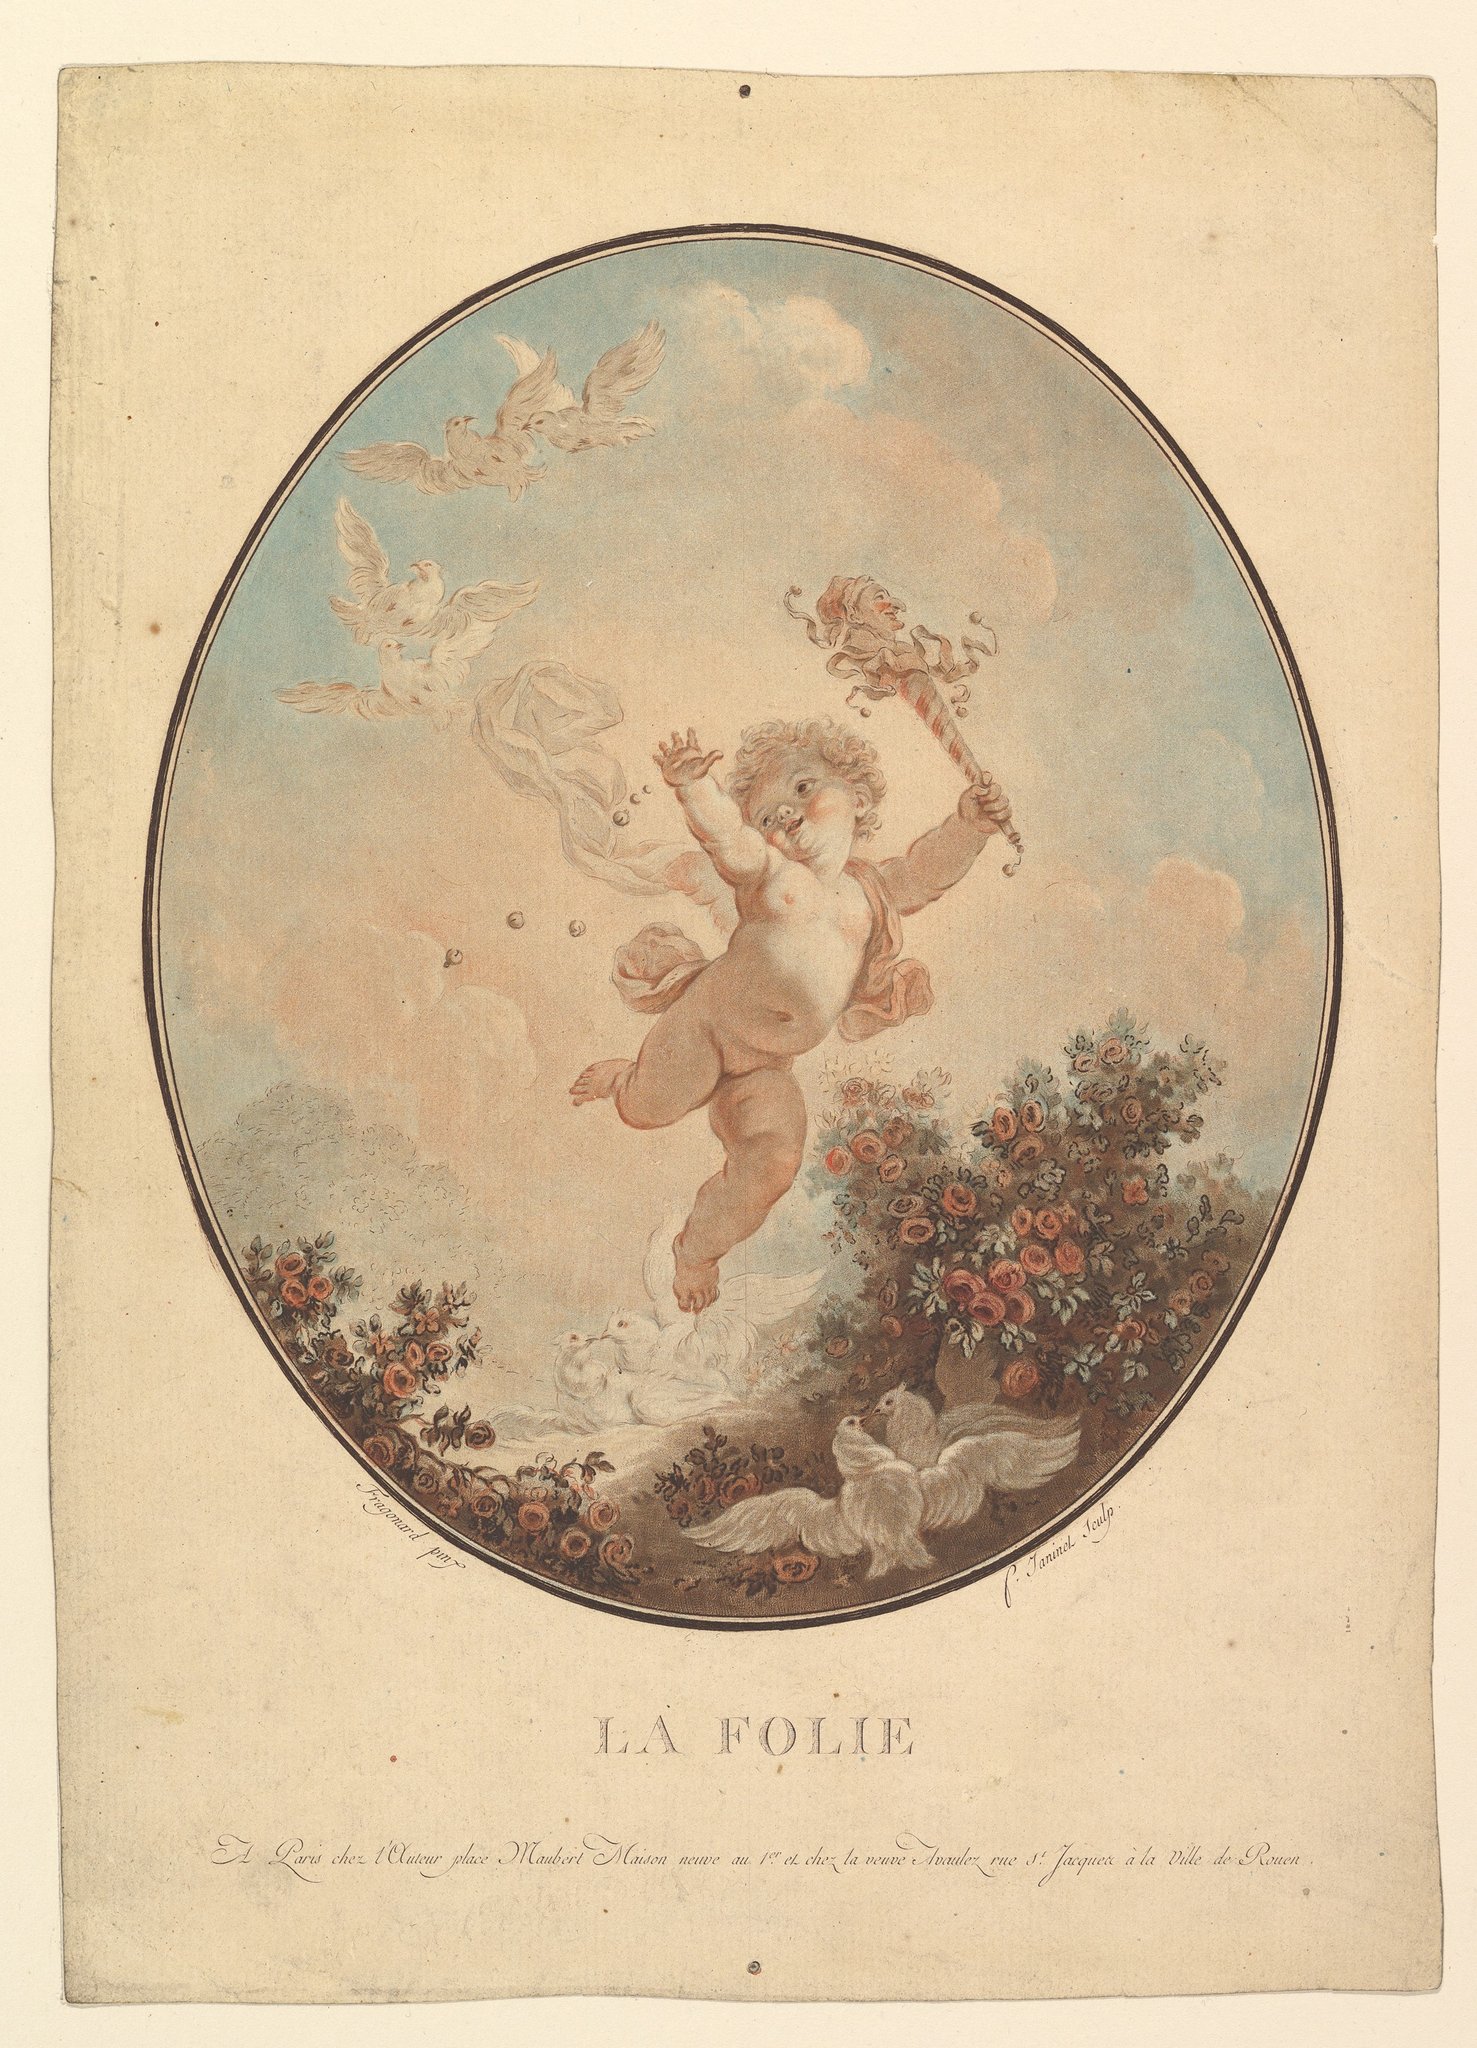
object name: print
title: La Folie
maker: jean françois janinet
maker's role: artist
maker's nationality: french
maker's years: 1752-1814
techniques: etching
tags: birds,putti